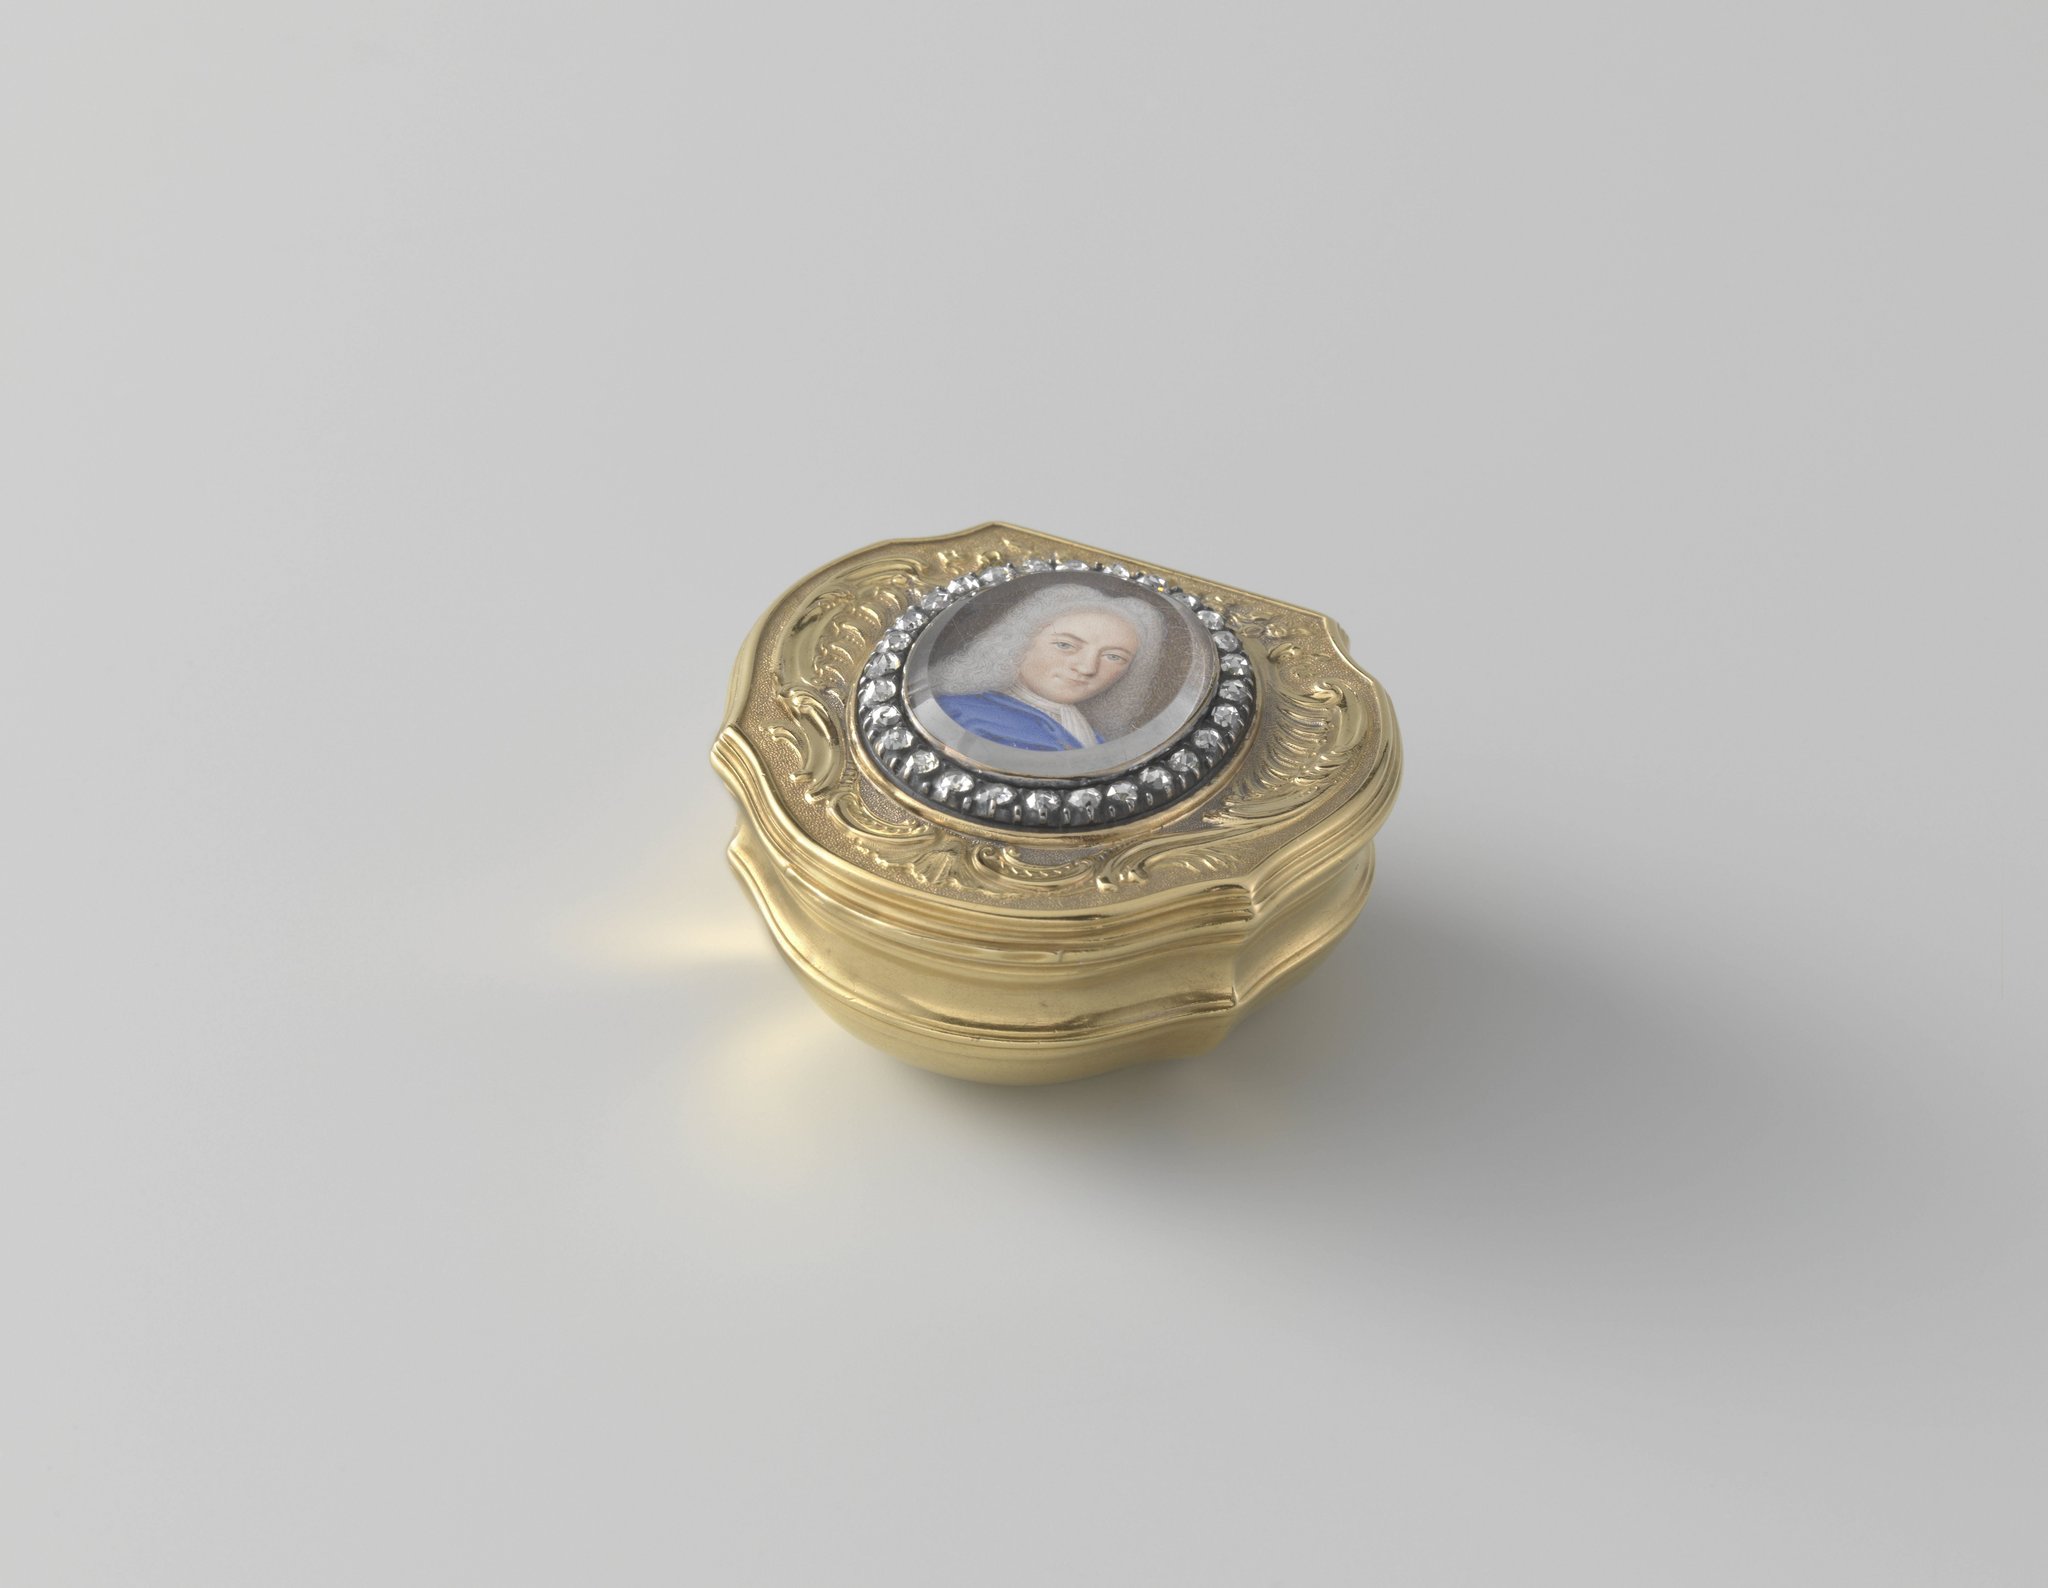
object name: miniature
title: Snuifdoos met portret van Nicolaas Pancras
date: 1743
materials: gemstone, diamond, glass, gold, parchment, silver, watercolor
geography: amsterdam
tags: nicolaas pancras, rocaille ornament, historical persons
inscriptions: alloy mark, town mark, date letter: ‘I’, maker's mark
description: Snuffbox. Gold. With a portrait of Nicolaas Pancras. Amsterdam, 1743, by Jean Soumain. Snuffbox. Gold. Middelburg, 1784 - 1786, by L. Potmans.